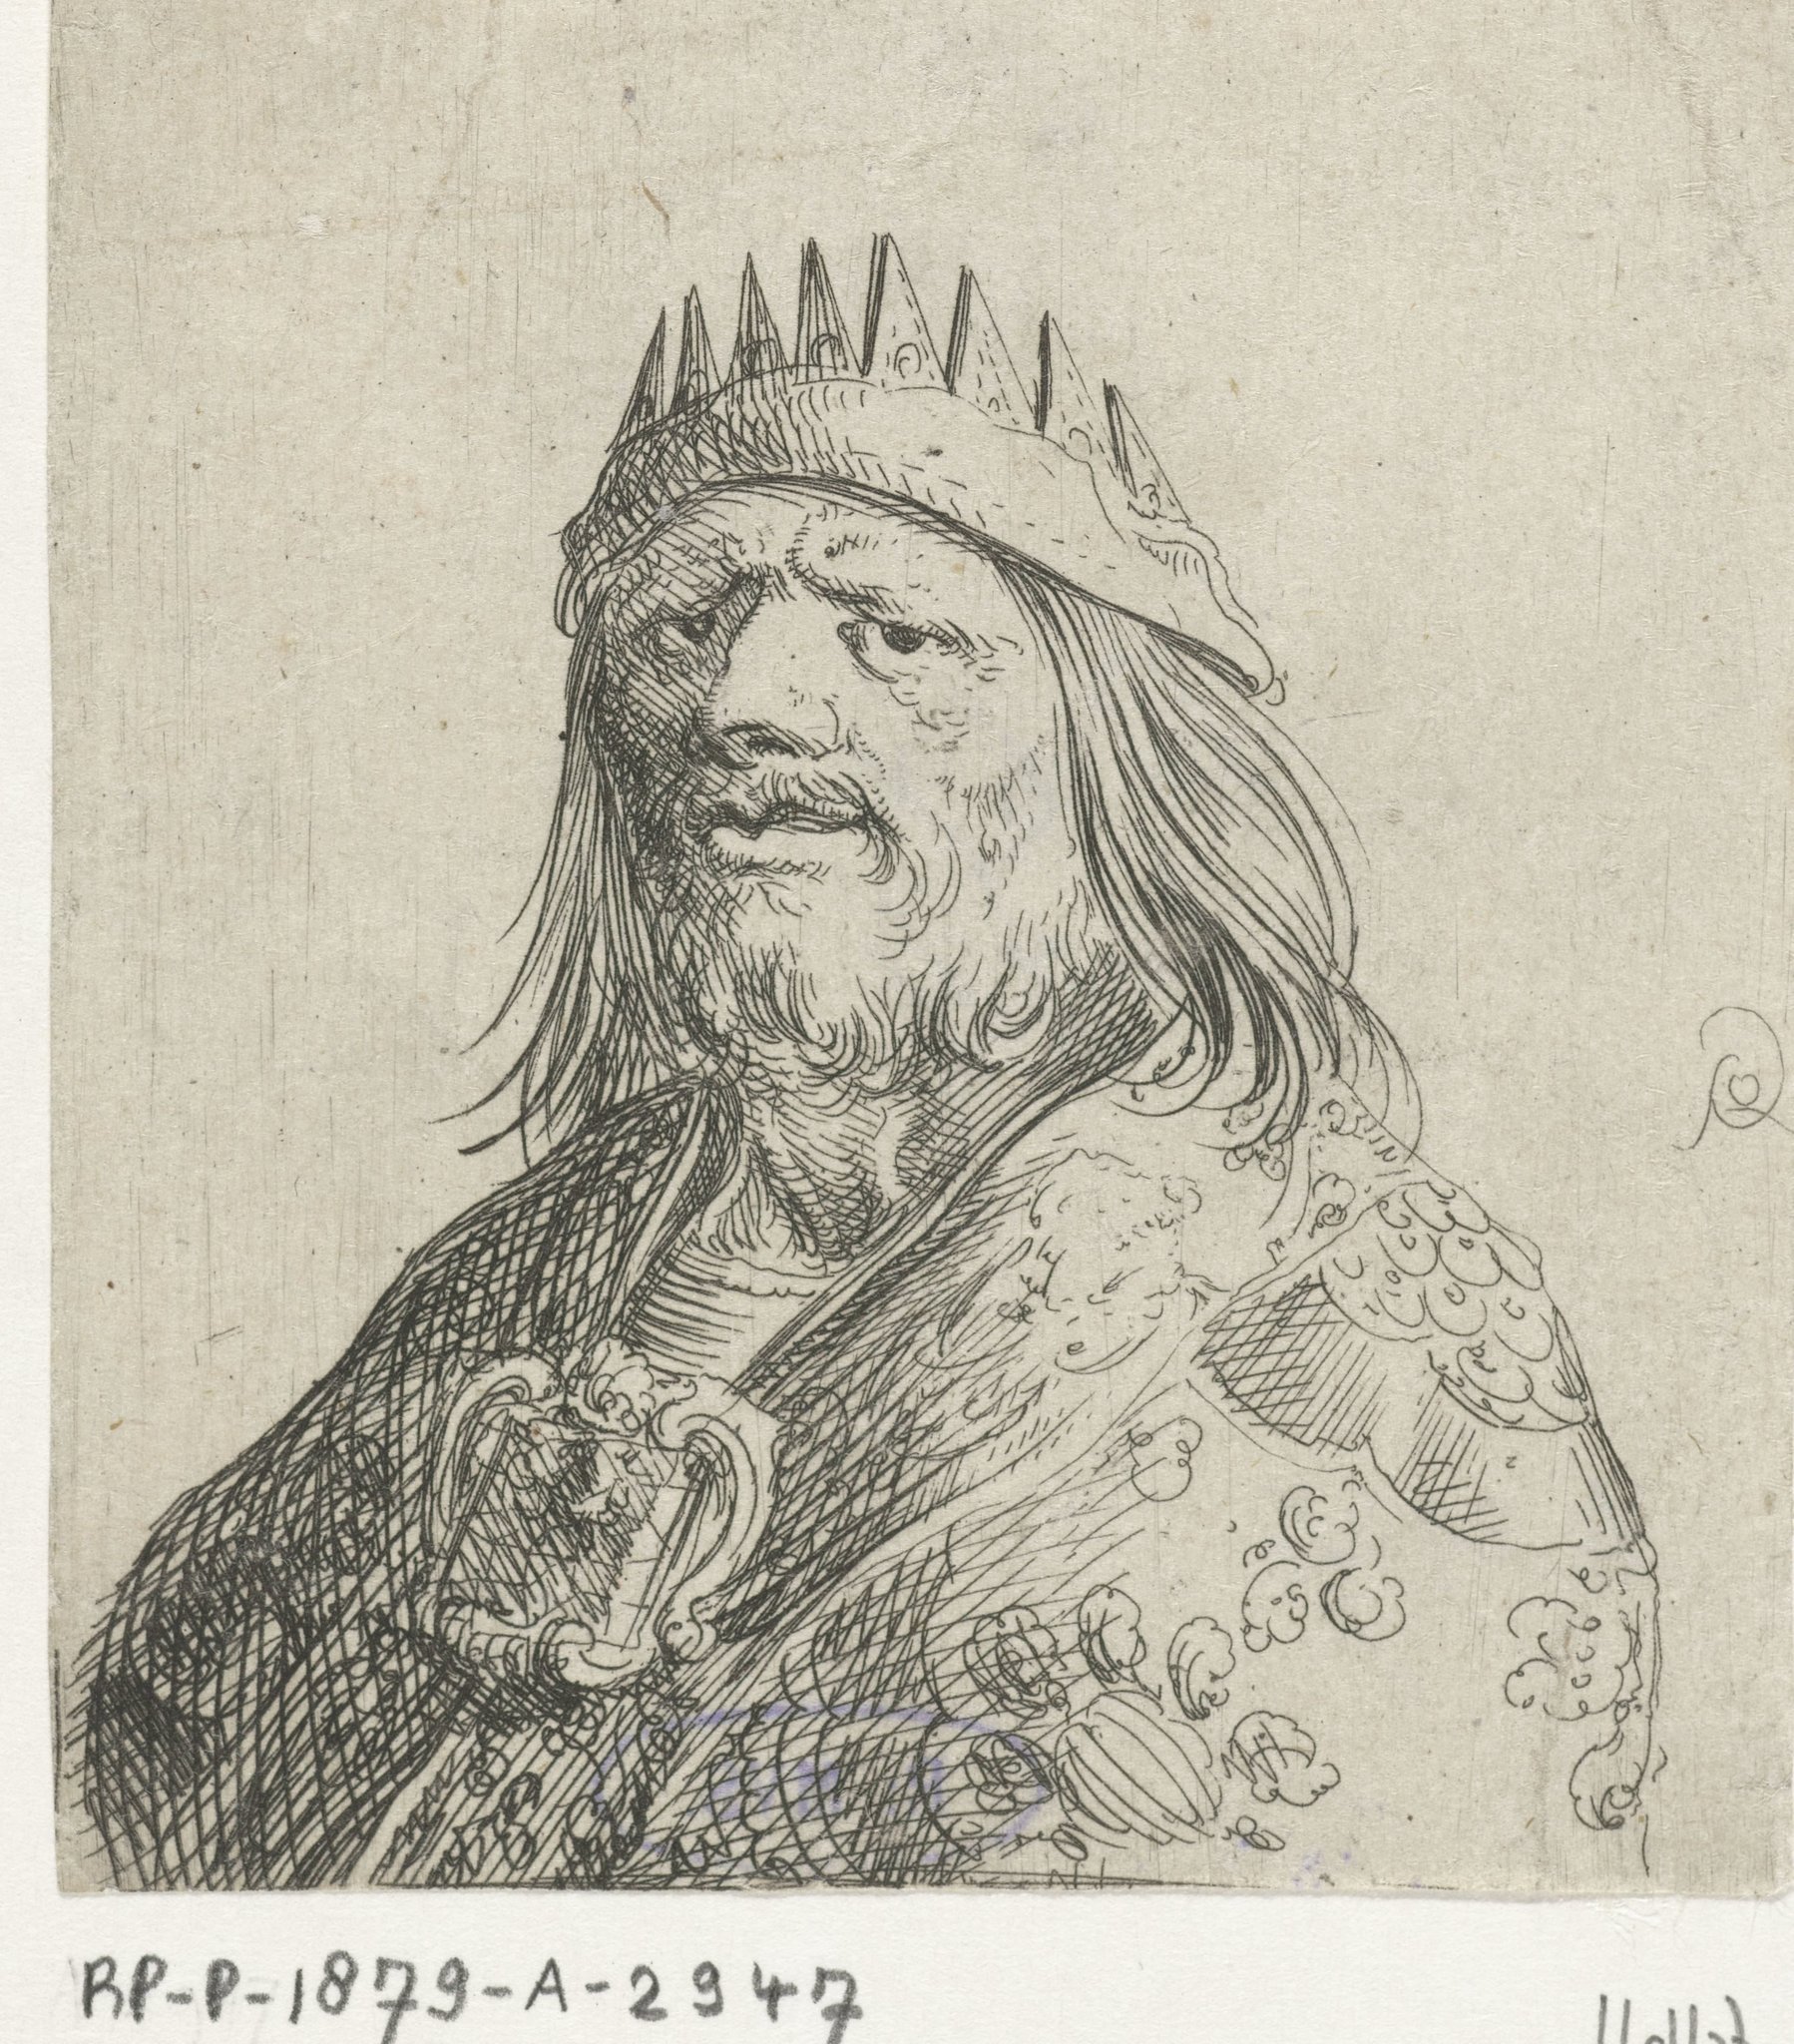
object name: print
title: Portretbuste van een koning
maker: pieter jansz quast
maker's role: draughtsman, painter, print maker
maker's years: 1605-1647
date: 1615-1647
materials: paper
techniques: etching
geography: netherlands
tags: crown (symbol of sovereignty), ruler, sovereign - bb - female ruler, armorial bearing, heraldry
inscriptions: collector's mark: Lugt 2228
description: Portretbuste van een koning (mogelijk koning David). Zijn sluike haren langs het hoofd en een versierde kroon op het hoofd. Op zijn mantel een gesp in de vorm van een wapenschild.